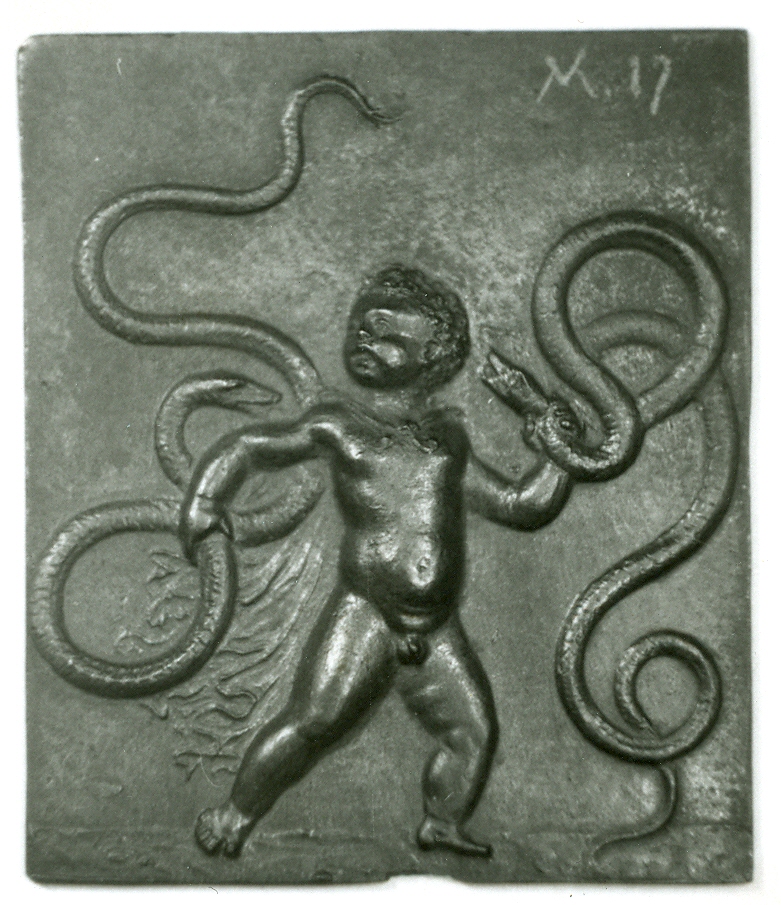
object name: plaquette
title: The Infant Hercules Strangling the Serpents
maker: master of the labours of hercules, verona (?)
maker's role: artist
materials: copper alloy, tin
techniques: soldering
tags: hercules,snakes